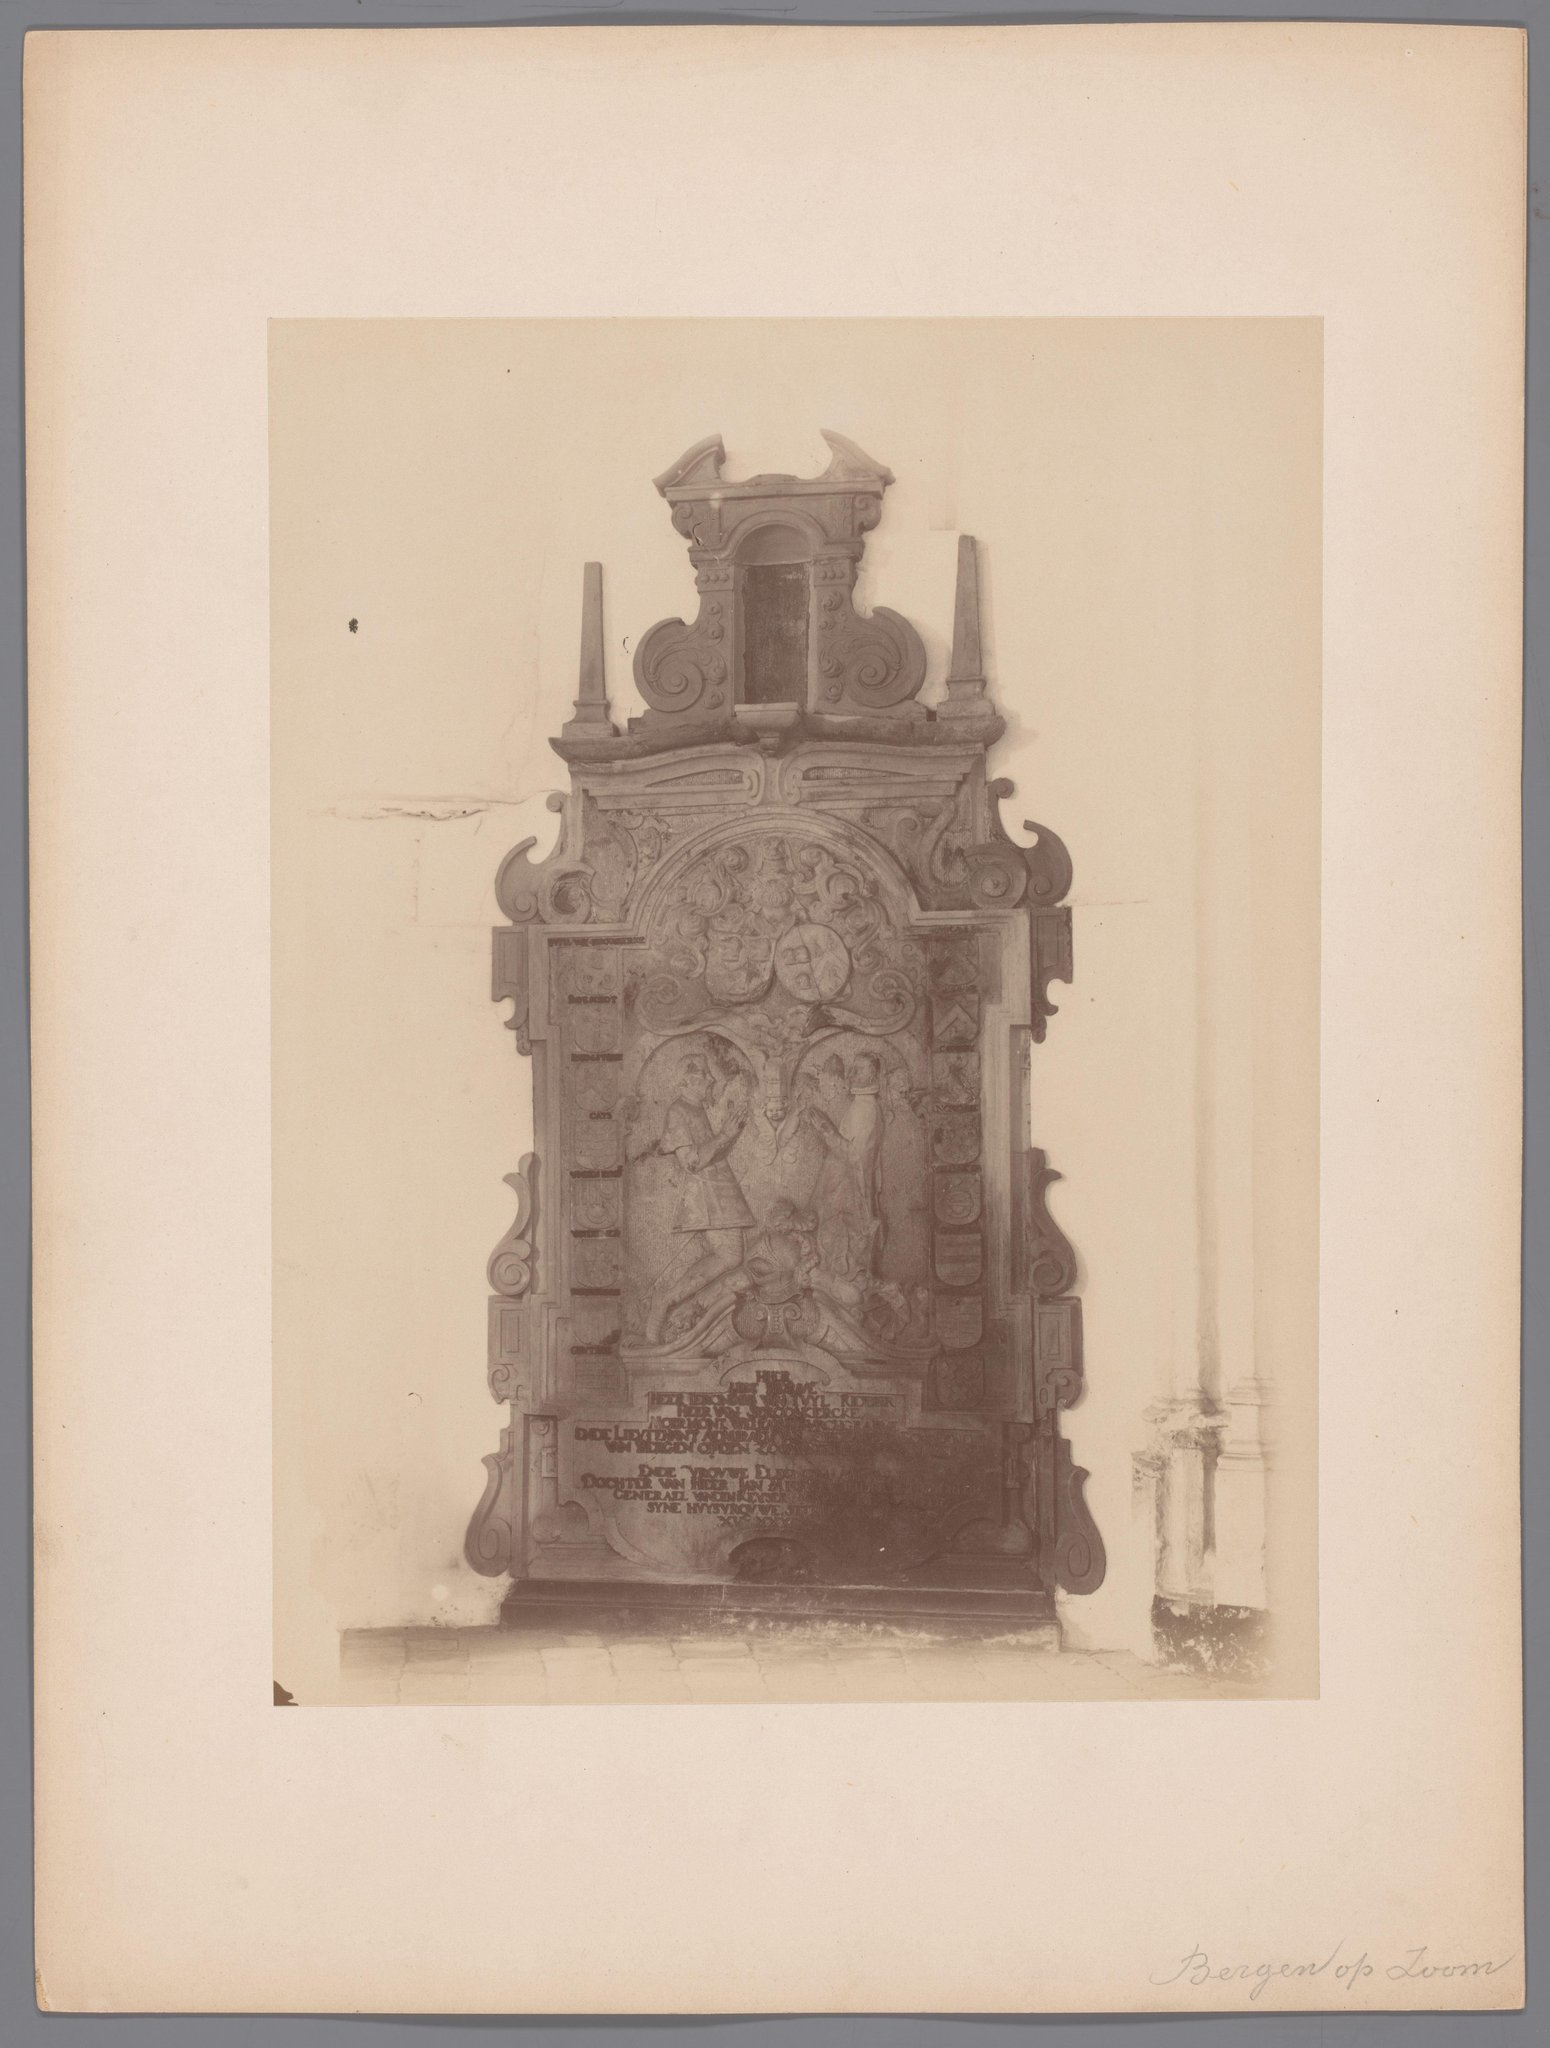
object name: photograph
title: Grafmonument van Hieronymus van Tuyll van Serooskerke en Eleonora Micault in de Sint-Gertrudiskerk te Bergen op Zoom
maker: anoniem (monumentenzorg)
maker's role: fotograaf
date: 1890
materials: cardboard, photographic support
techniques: albumen print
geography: bergen op zoom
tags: grave-building, monumental tomb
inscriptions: annotation: ‘Bergen op Zoom’, annotation: ‘Grafmonument in de Kerk v/d N.H. gemeente te Bergen-op-Zoom/ Sept 1890’